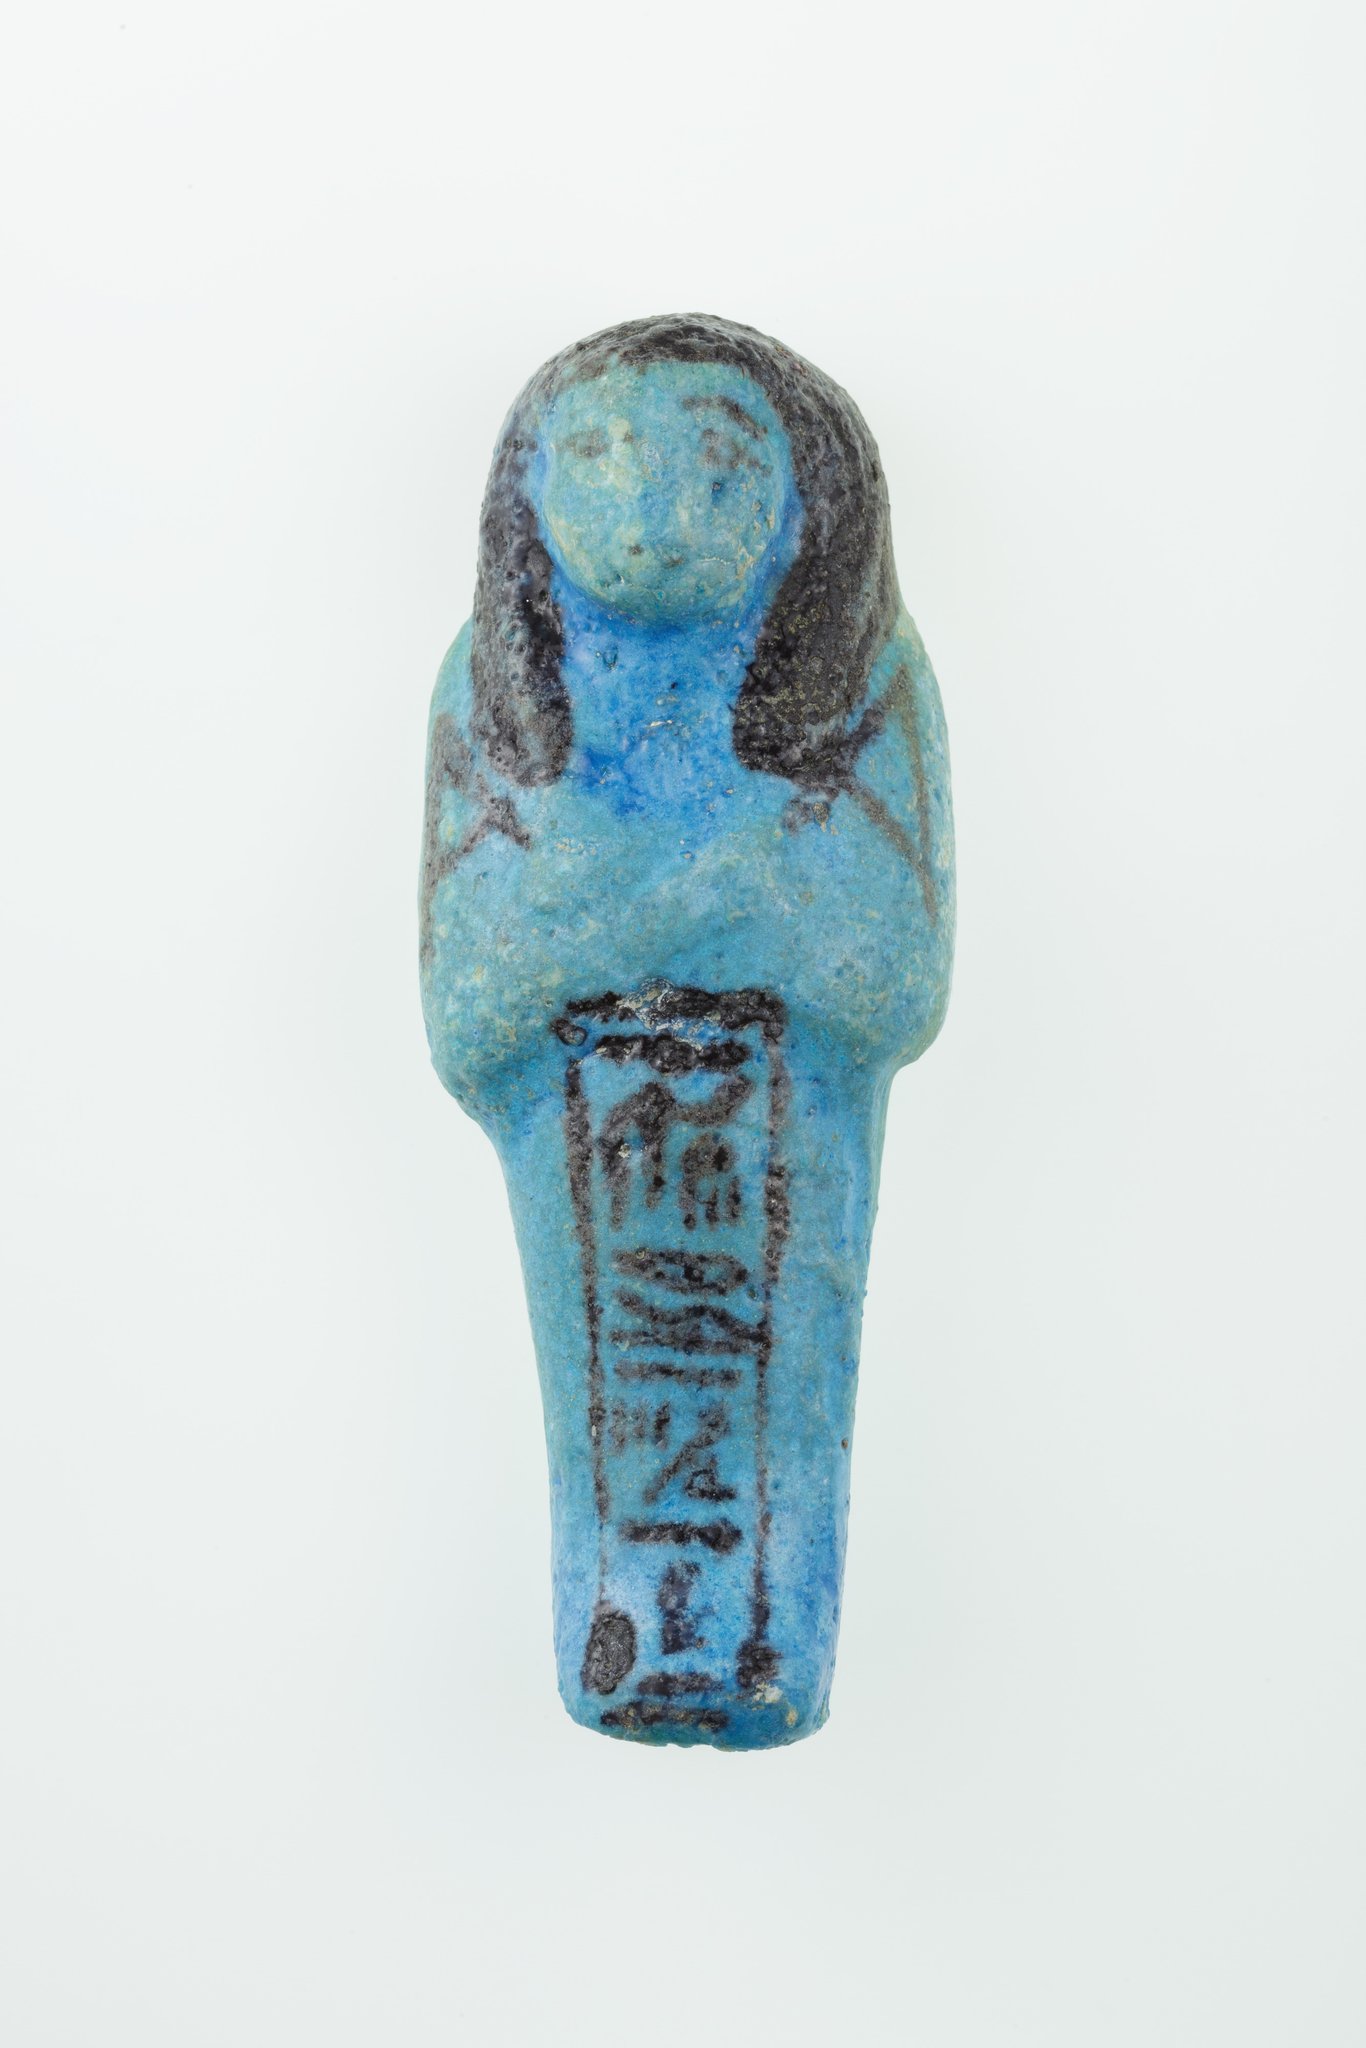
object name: shabti, worker, nauny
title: Worker Shabti of Nauny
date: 1050 BCE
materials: faience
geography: egypt